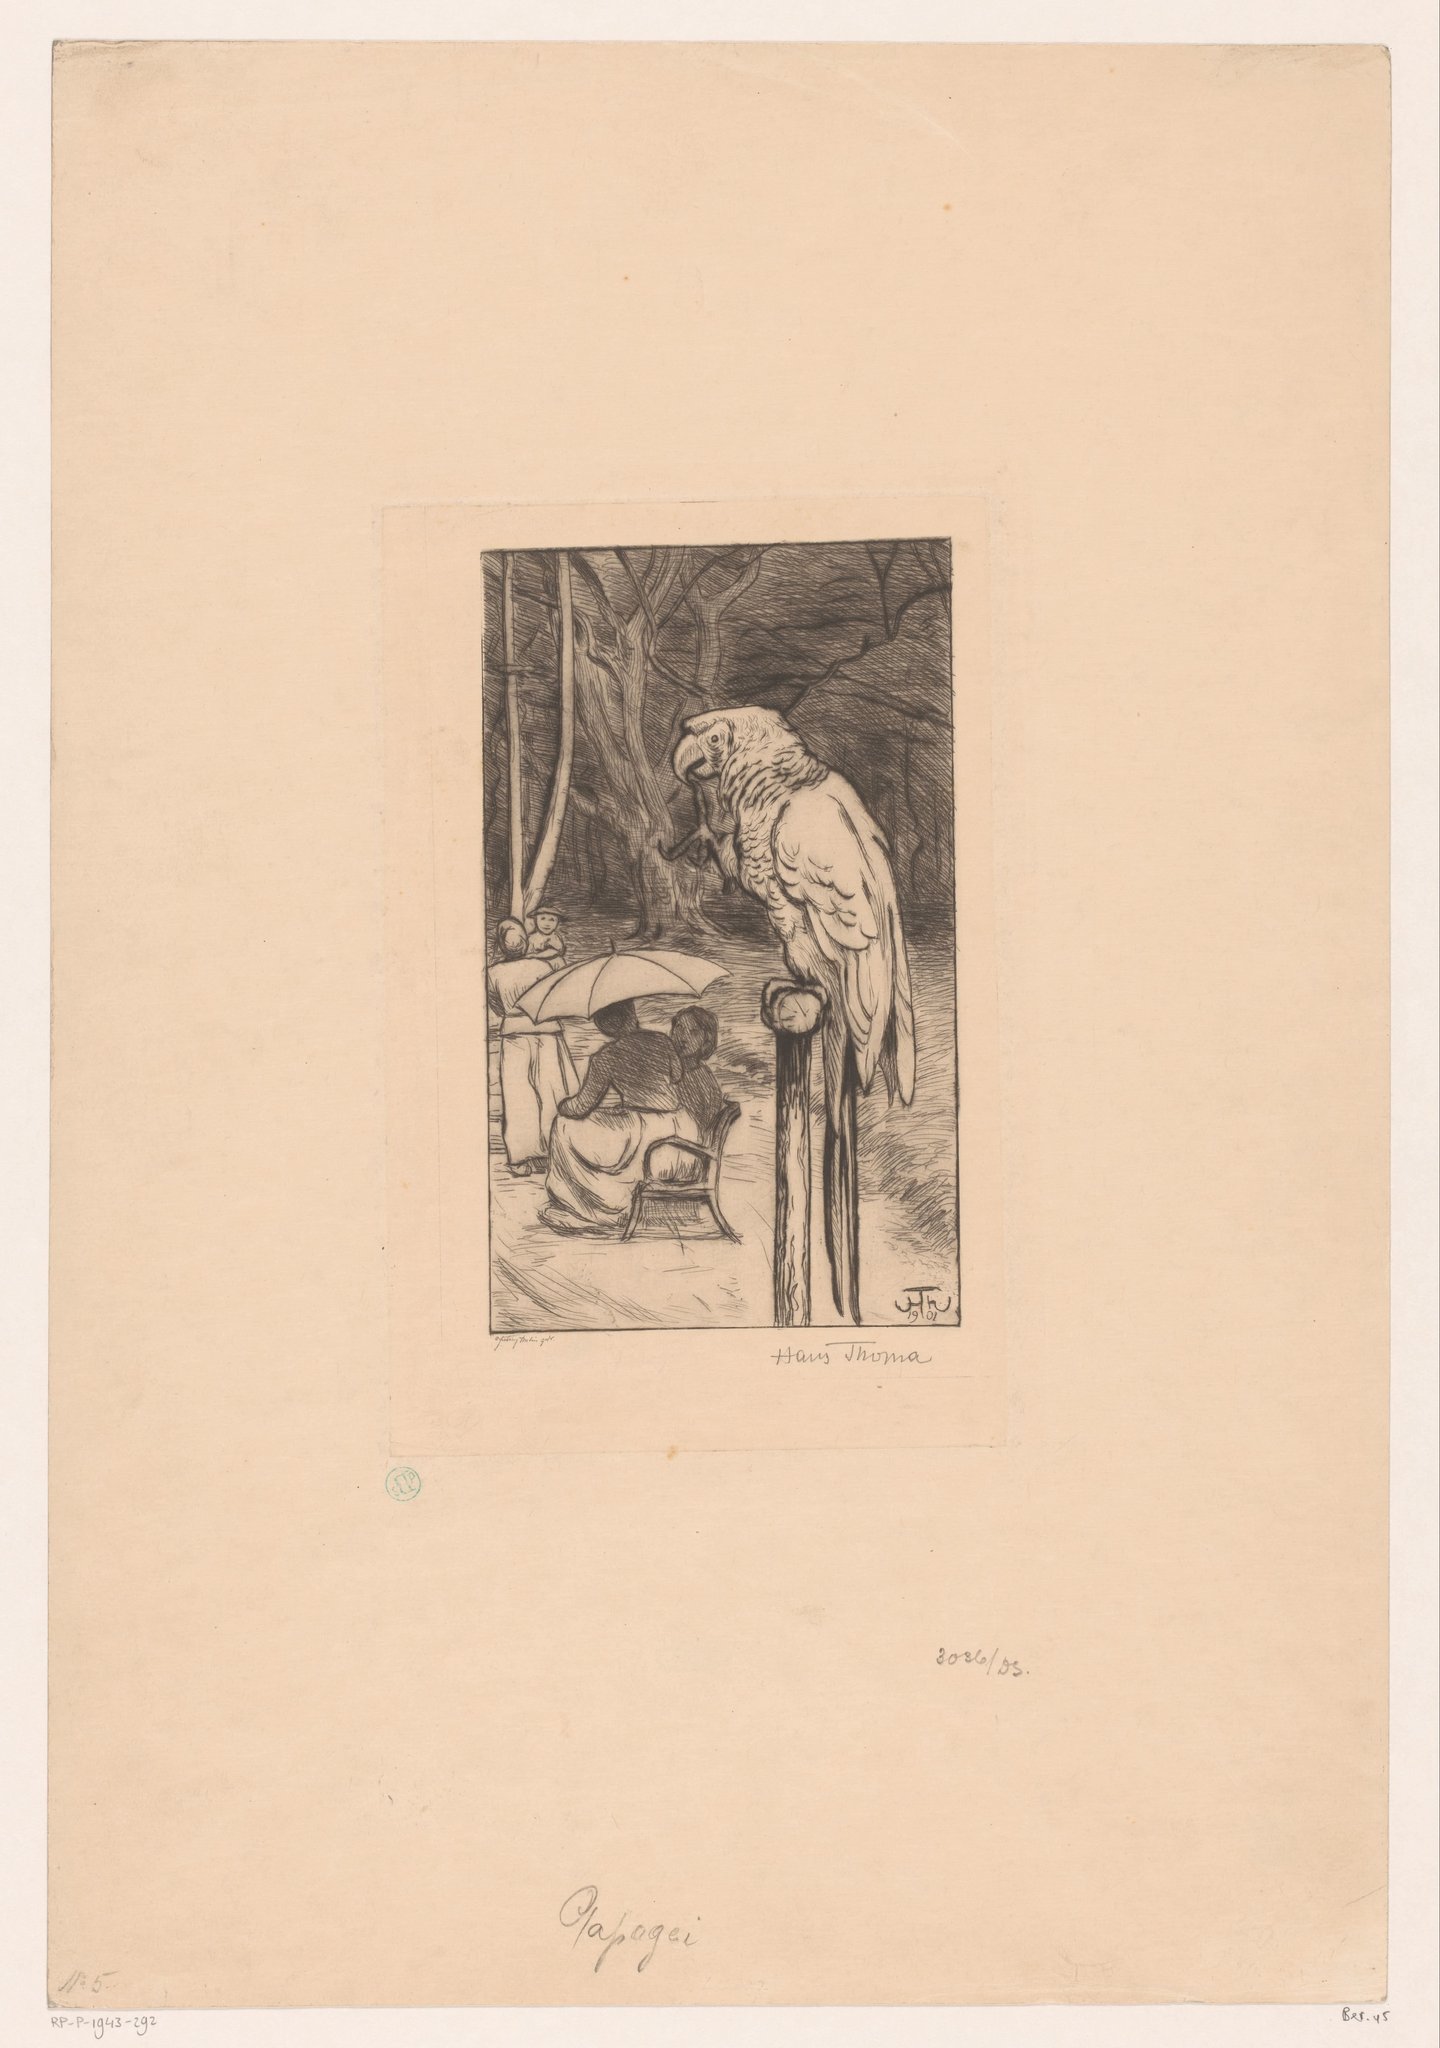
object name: print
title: Papegaai en vier figuren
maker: hans thoma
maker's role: painter, print maker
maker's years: 1839-1924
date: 1901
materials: paper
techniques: drypoint, etching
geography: karlsruhe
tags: ornamental birds: parrot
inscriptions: collector's mark: Lugt 2228, inscription: ‘f 65-’, collector's mark: Lugt 2760, collector's mark: Lugt 602, collector's mark: Lugt 733, number: ‘No. 5’